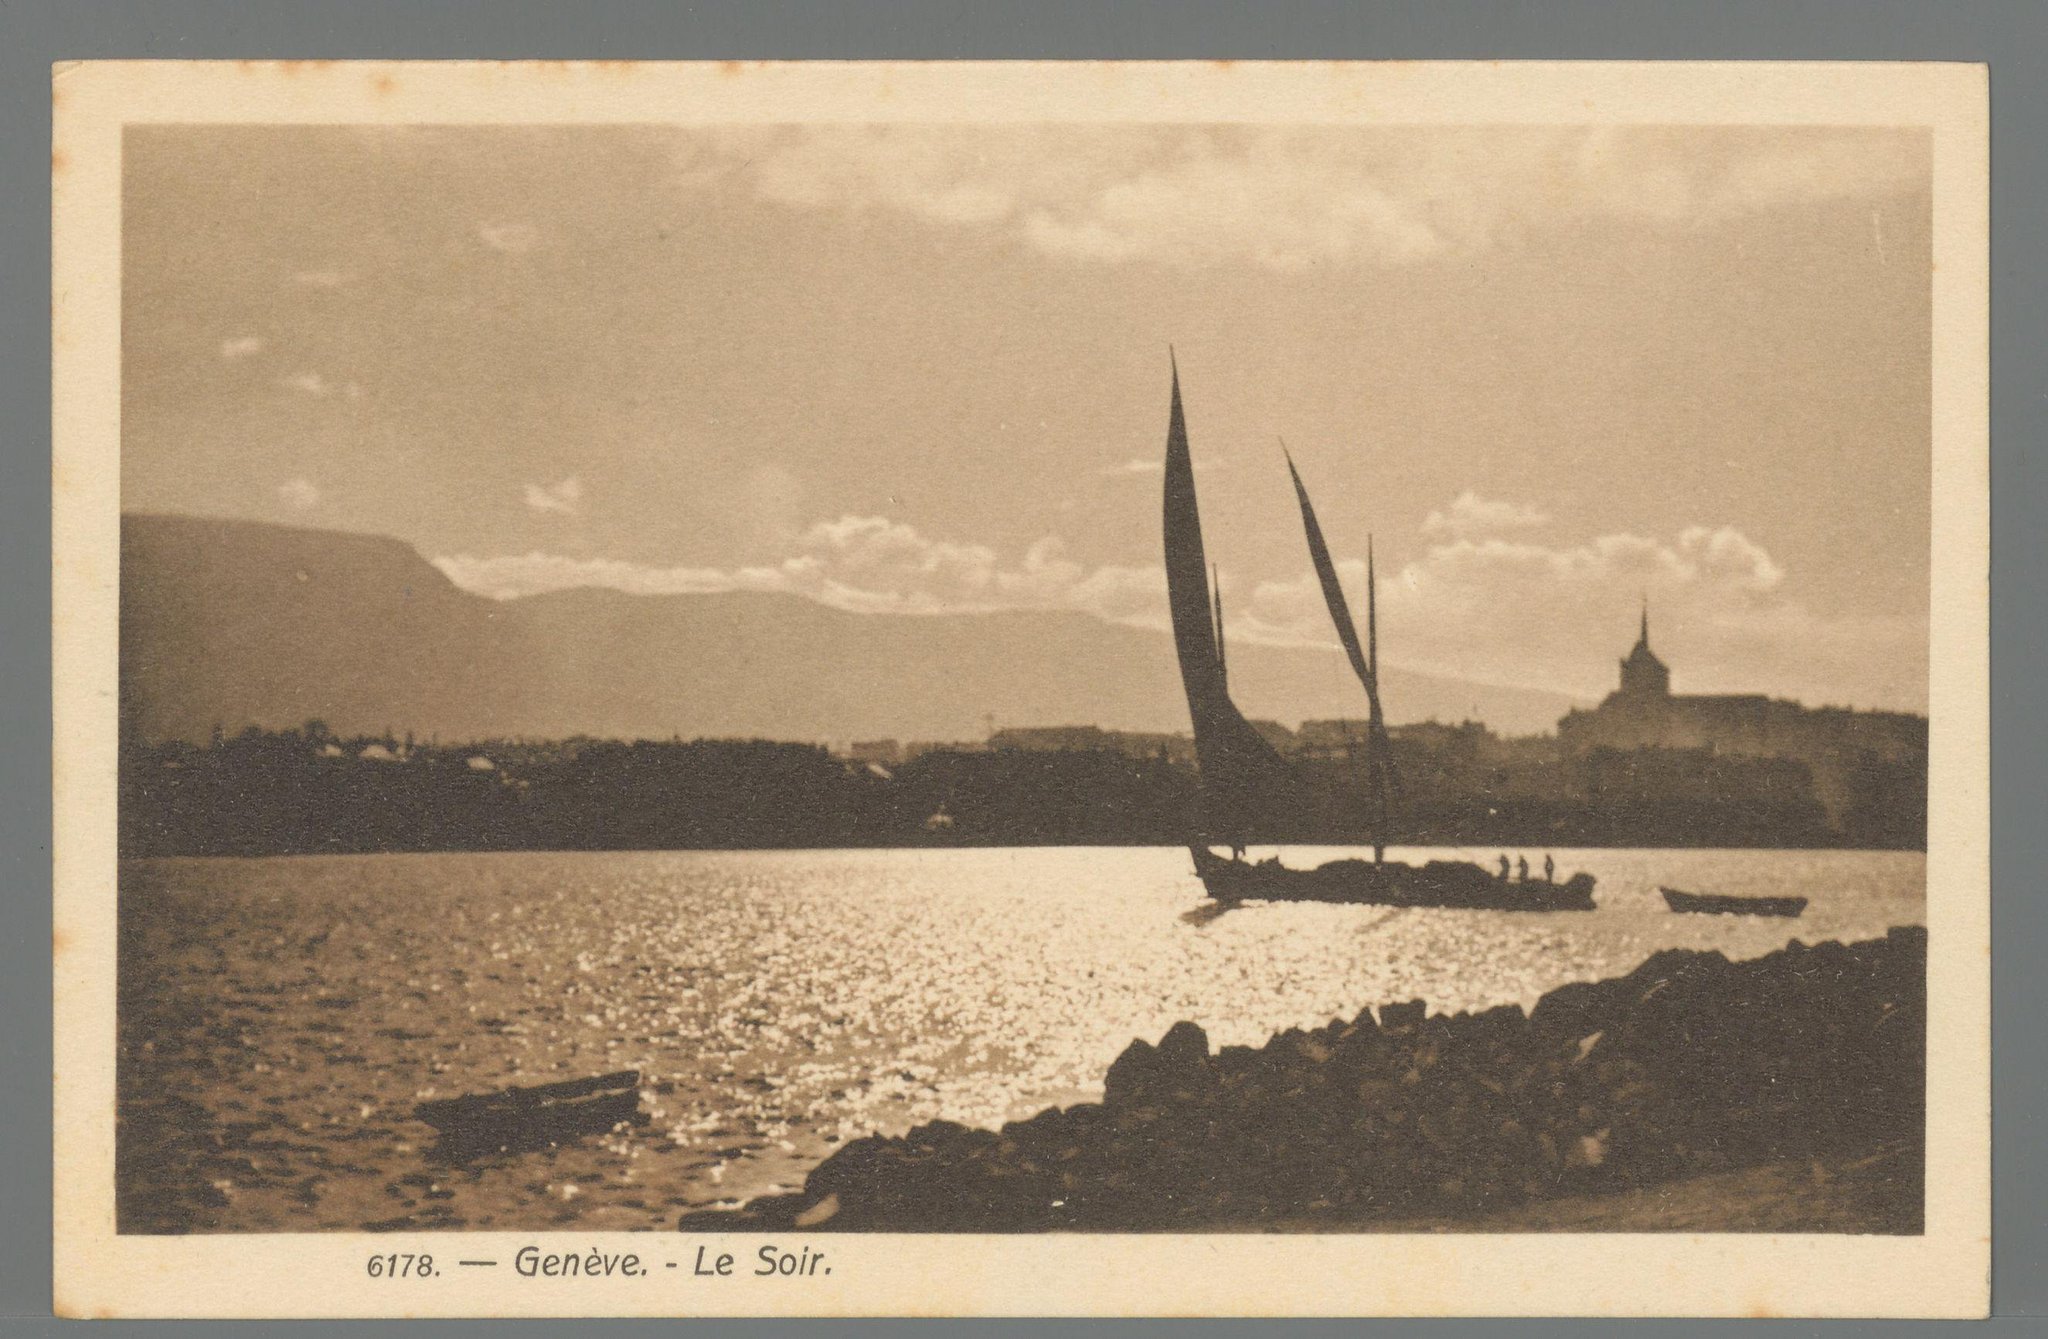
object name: photomechanical print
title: Genève. Le Soir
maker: Anonymous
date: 1905-1909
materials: cardboard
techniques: photograph, writing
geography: geneva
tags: dusk, evening twilight, lake, prospect of city, town panorama, silhouette of city